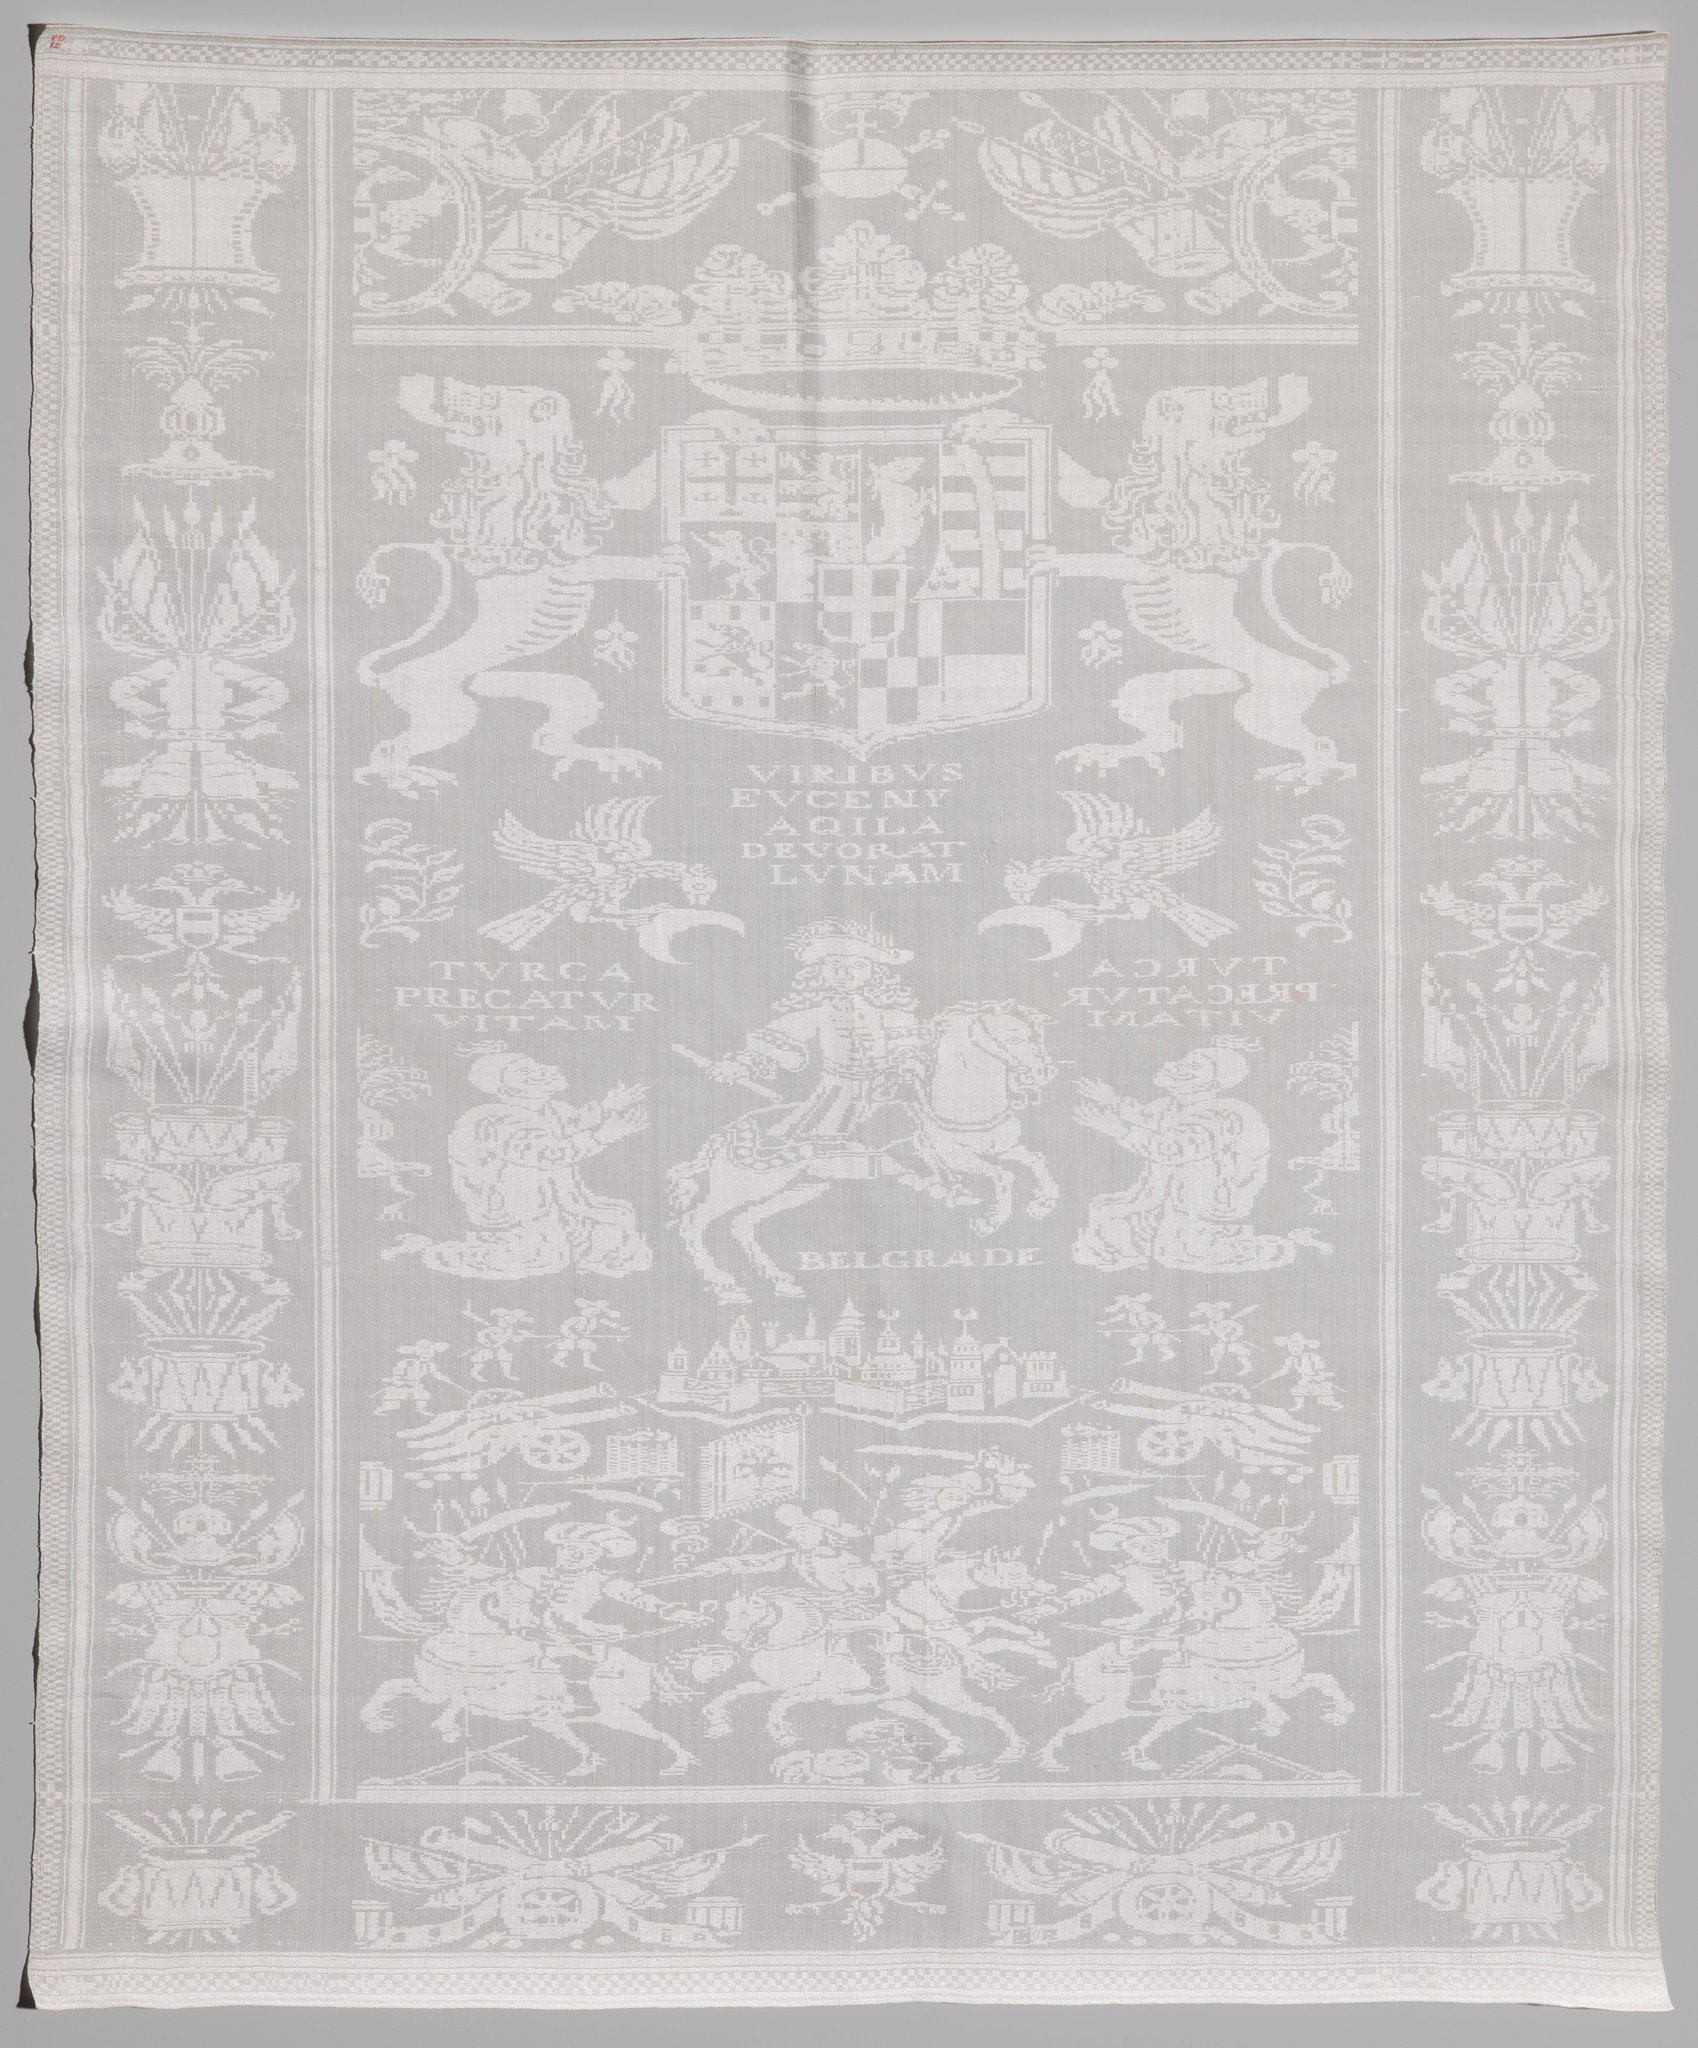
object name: napkin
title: Servet van wit linnendamast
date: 1717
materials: linen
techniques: damask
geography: flanders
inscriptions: mark: ‘VD 12’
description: Wit linnen damasten servet met de verovering van Belgrado door Eugenius van Savoye, waarin ingeweven een ruitergevecht, een ruiterportret en het wapen van de prins en de inschriften VIRIBVS EVGENY AQILA DEVORAT LVNAM / TVRCA PRECATVR VITAM / BELGRADE.